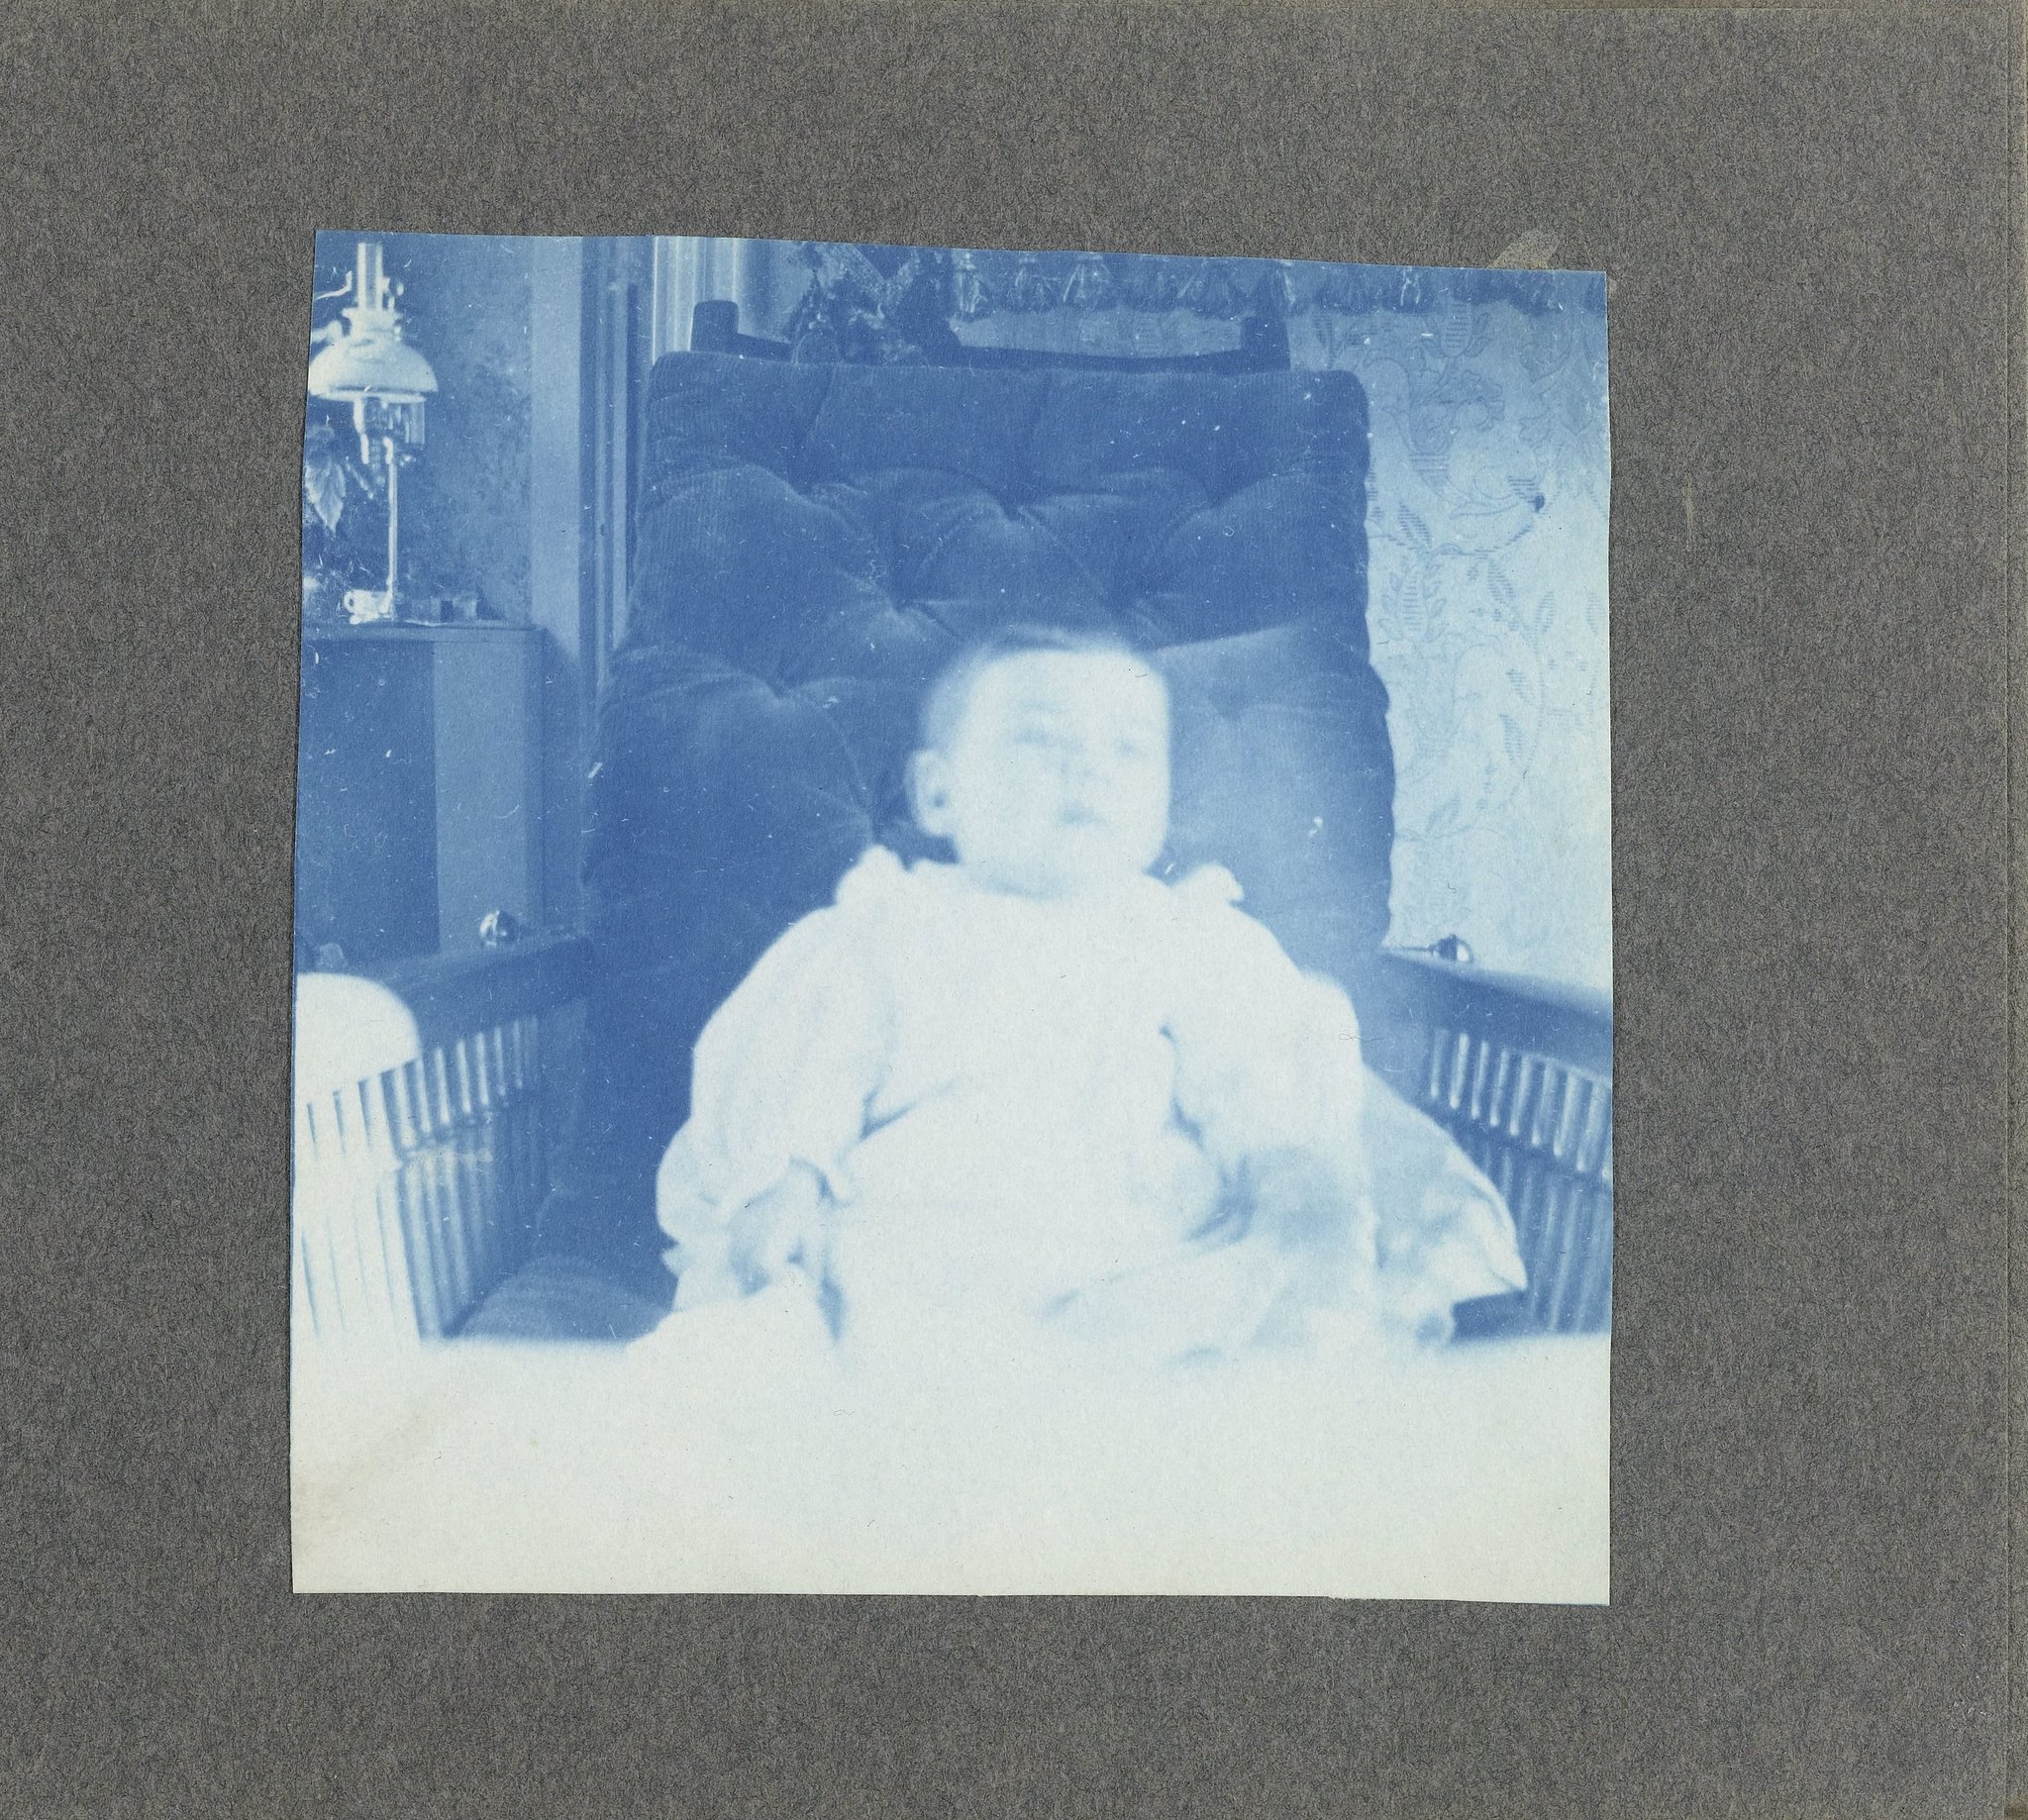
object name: photograph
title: Kind zittend in een stoel, Verenigde Staten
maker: Anonymous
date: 1900-1920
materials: paper, photographic support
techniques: cyanotype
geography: united states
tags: historical persons, infant, baby ~ the ages of man, united states of america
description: Onderdeel van Fotoalbum met 53 cyanotypieën van kinderen, paarden, huizen, boten en strandtaferelen in de Verenigde Staten.